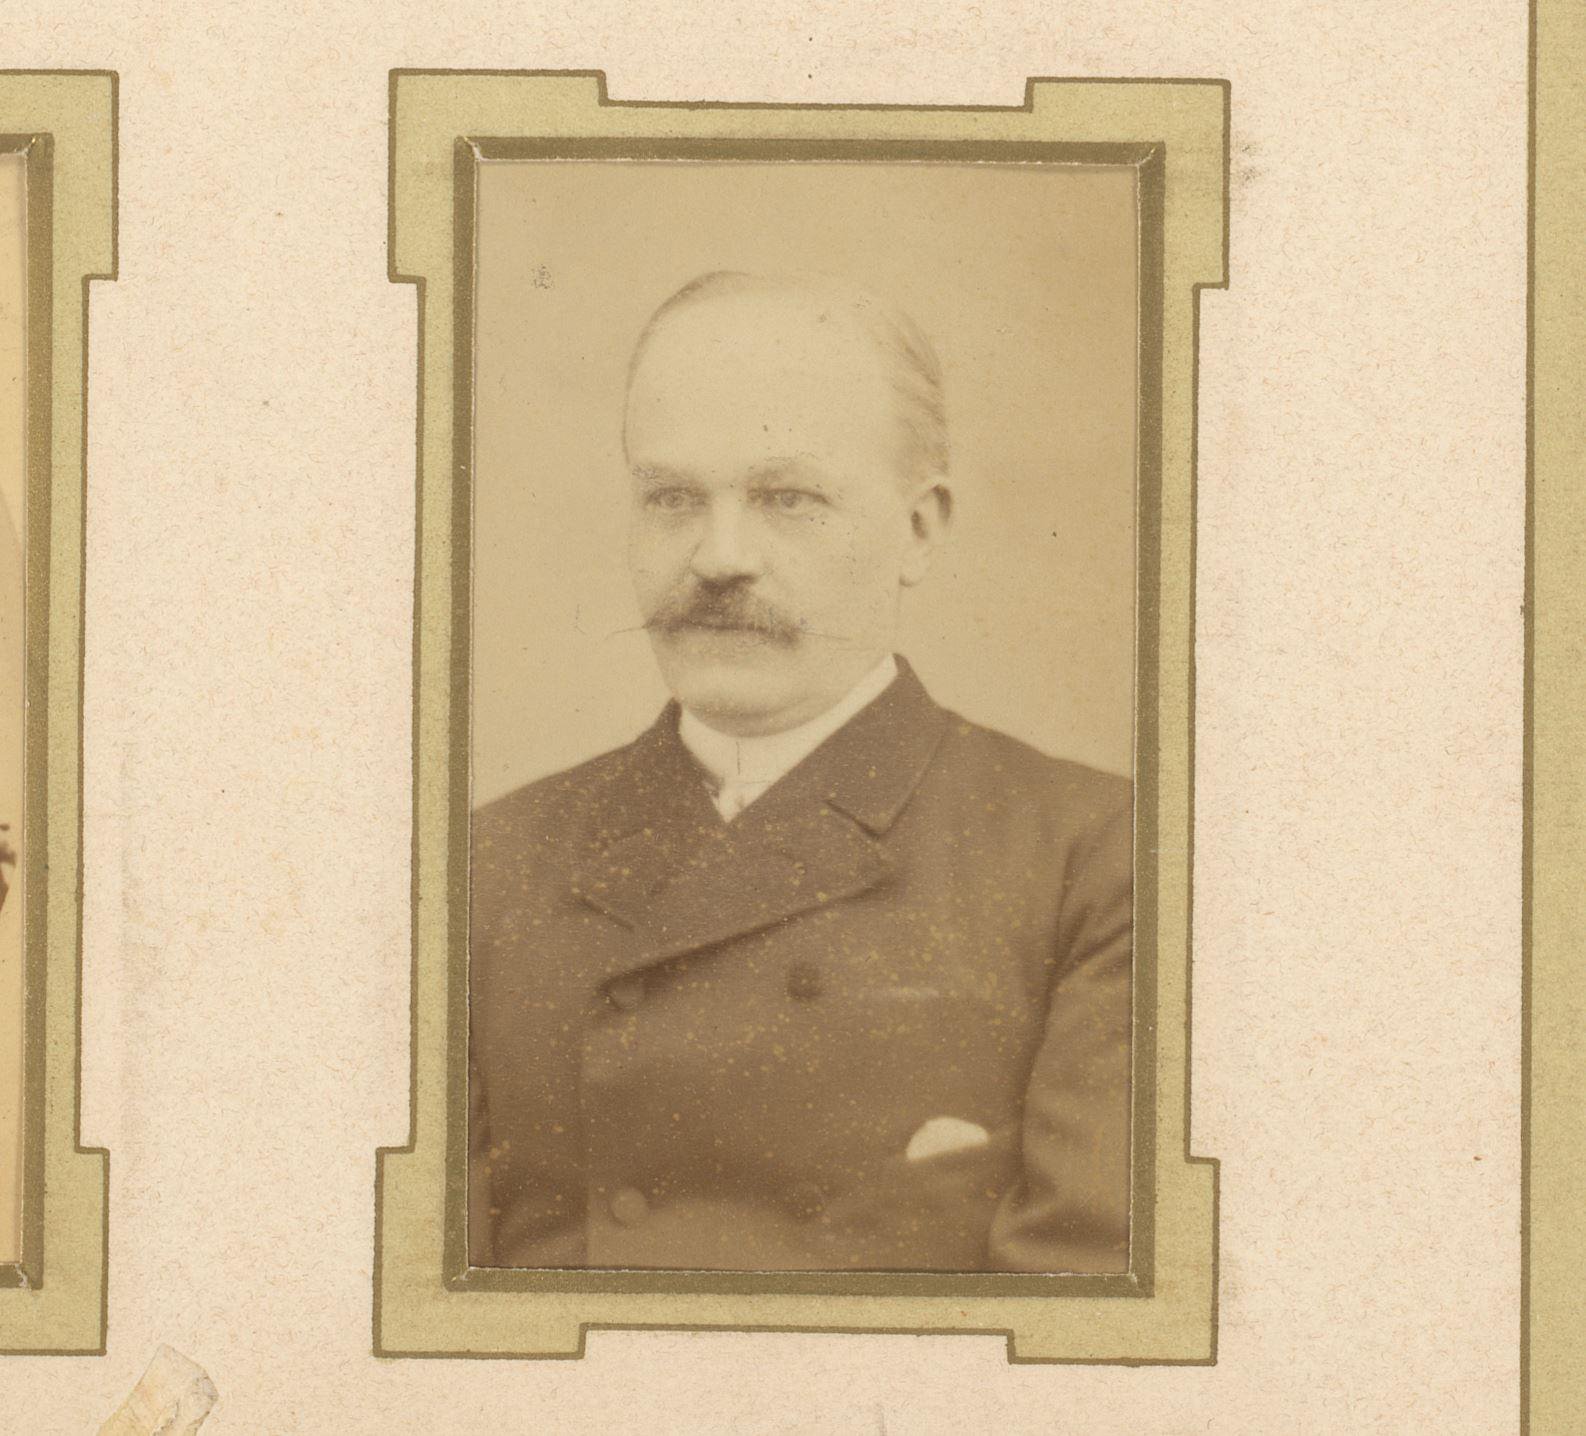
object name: photograph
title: Portret van een man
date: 1860-1900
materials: cardboard, photographic support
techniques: albumen print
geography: leuven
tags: historical persons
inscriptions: inscription: ‘Grande Photographie du Brabant/ Lambert et Léon Renard Frères/ 139, Rue de Malines 139/ Louvain’